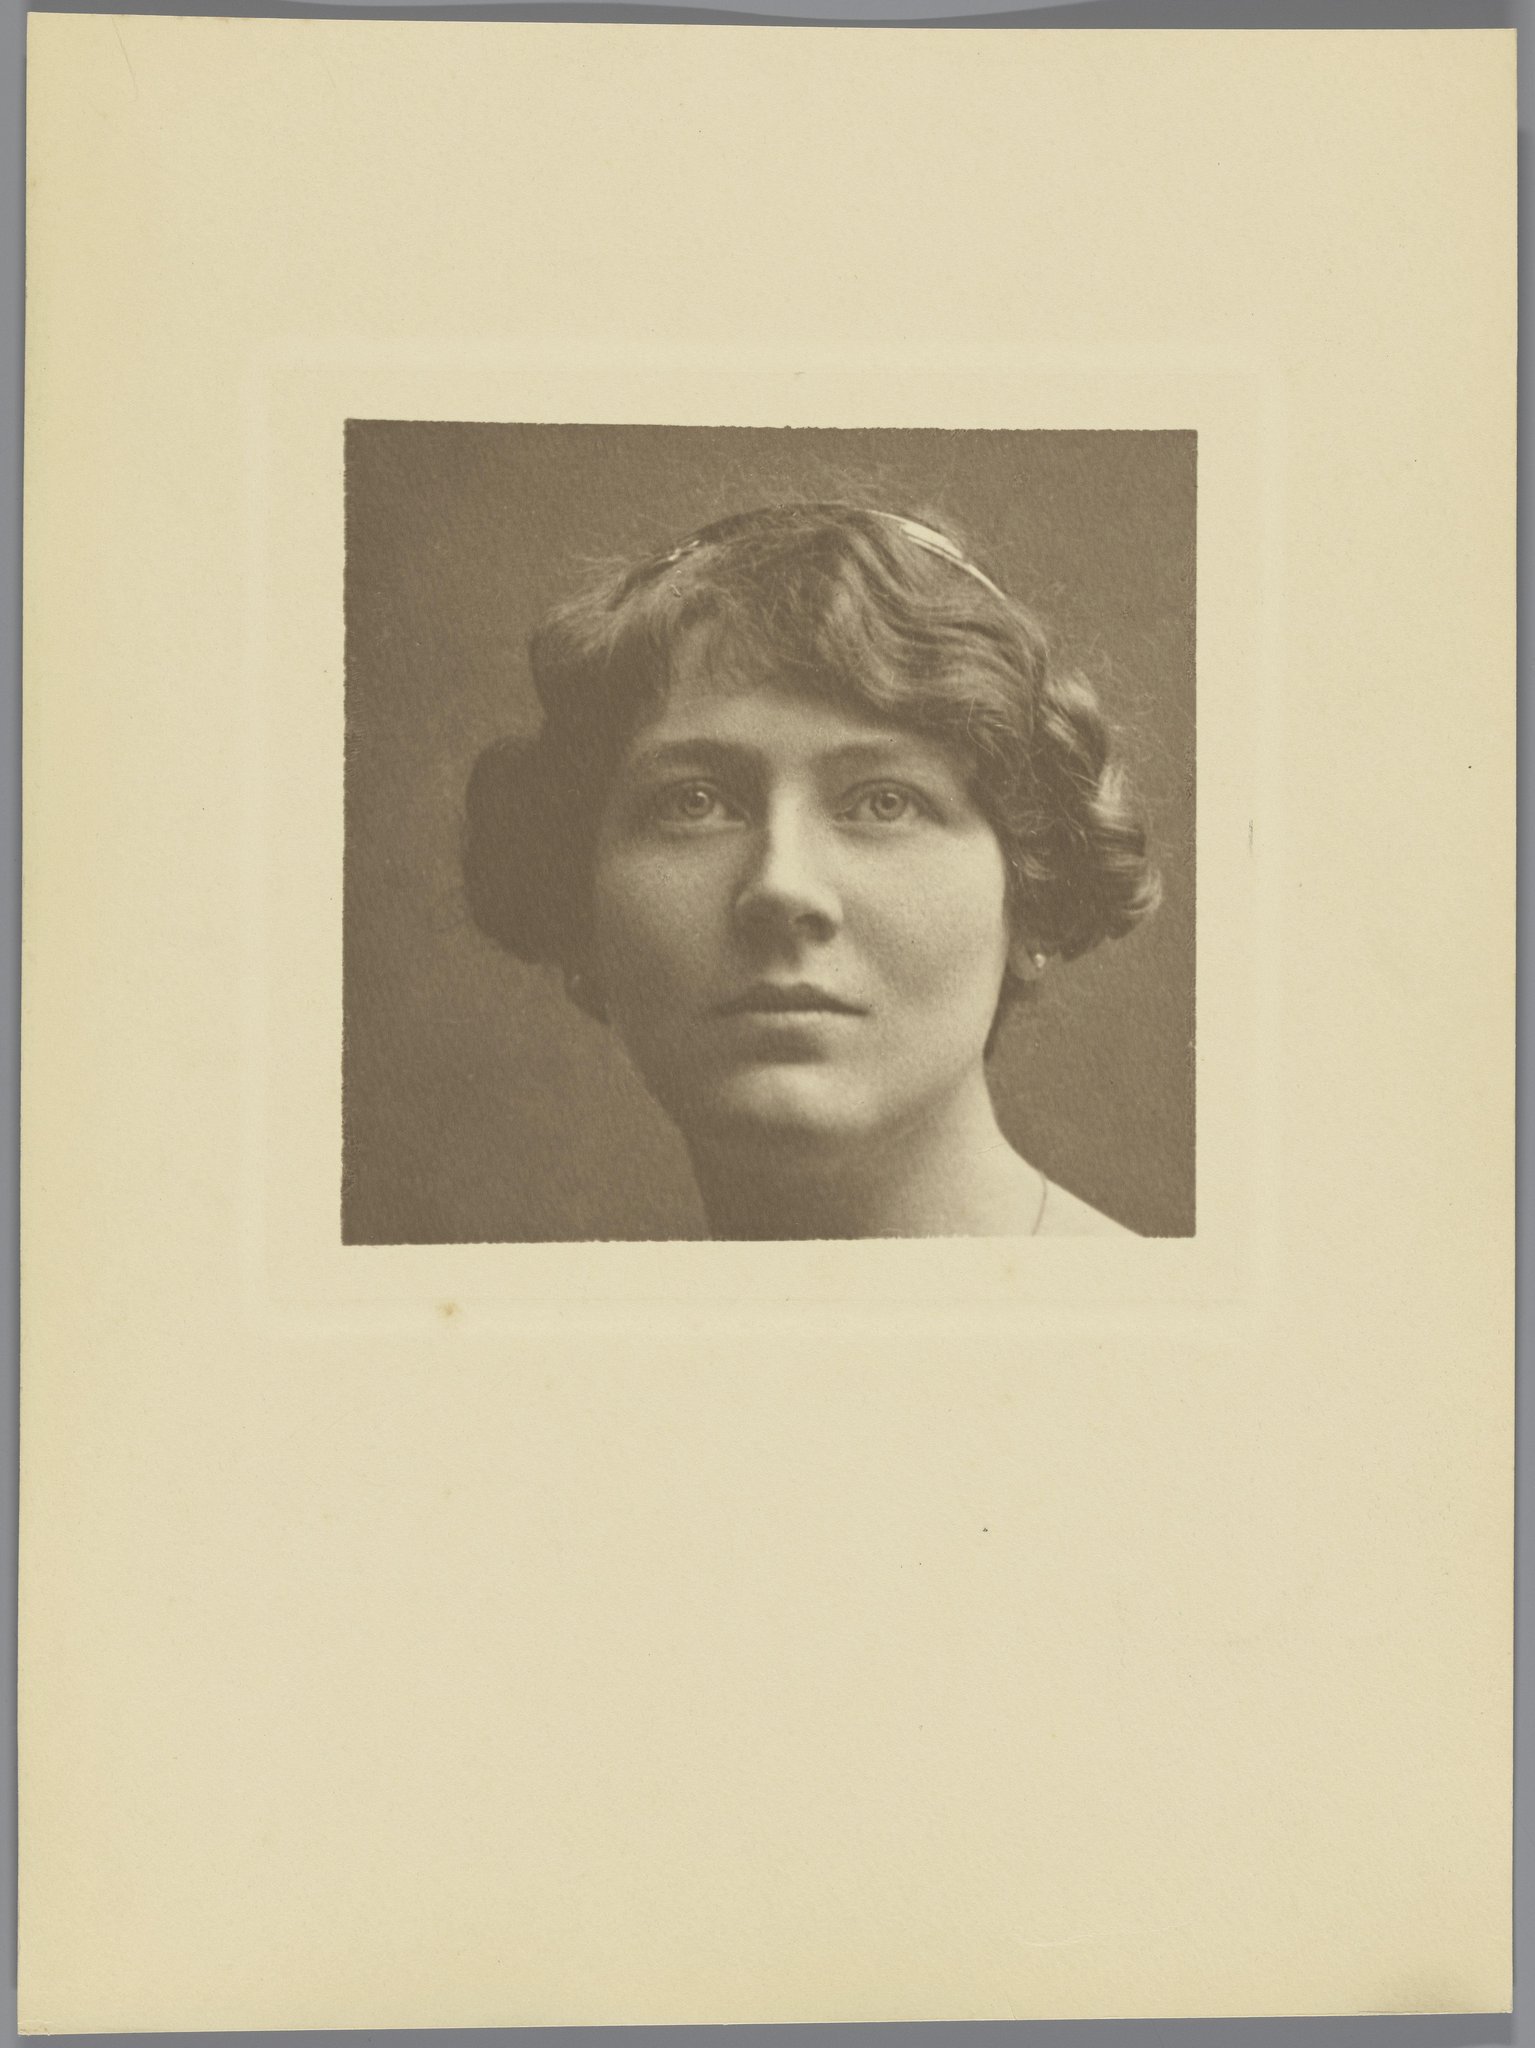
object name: photograph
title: Portret van een onbekende vrouw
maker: Anonymous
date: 1891-1896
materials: paper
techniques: gelatin silver print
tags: adult woman, historical persons not known by name - bb - woman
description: Deze foto wordt niet genoemd in de publicatie van de Troisième Exposition d'Art Photographique. Mogelijk is hij later aan het omslag toegevoegd.